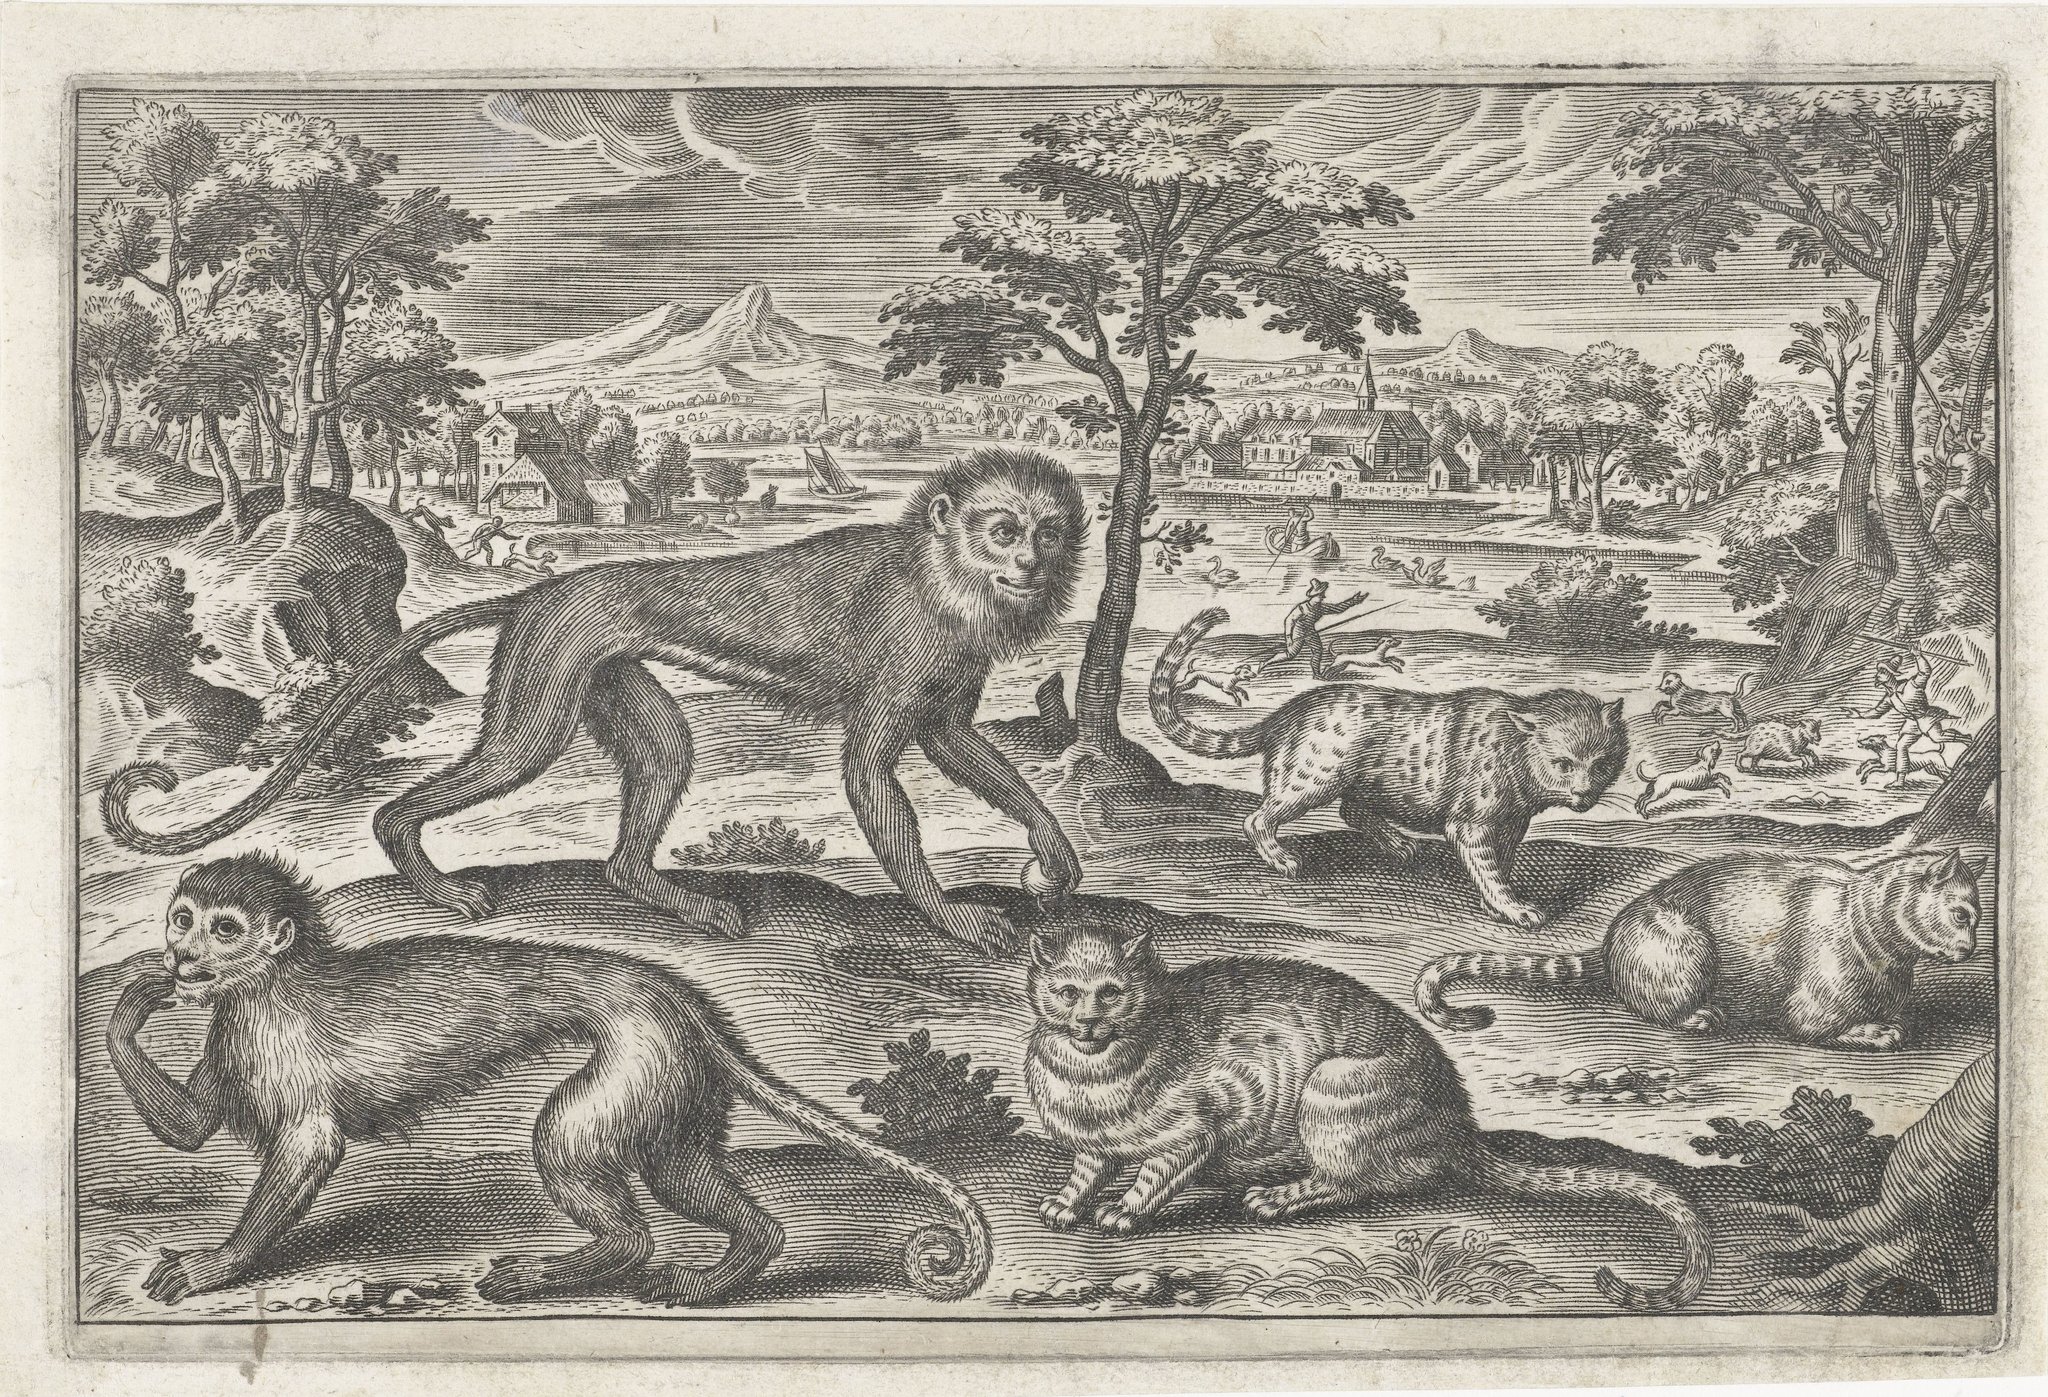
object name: print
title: Apen en katten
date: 1595-1652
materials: paper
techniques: engraving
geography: amsterdam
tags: cat, monkeys, apes, forest, wood, monkey hunting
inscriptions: collector's mark: Lugt 2228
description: Twee apen en drie katten op de voorgrond. Op de achtergrond een landschap met enkele mannen die jacht maken op apen. De prent maakt deel uit van een serie met als onderwerp dieren.